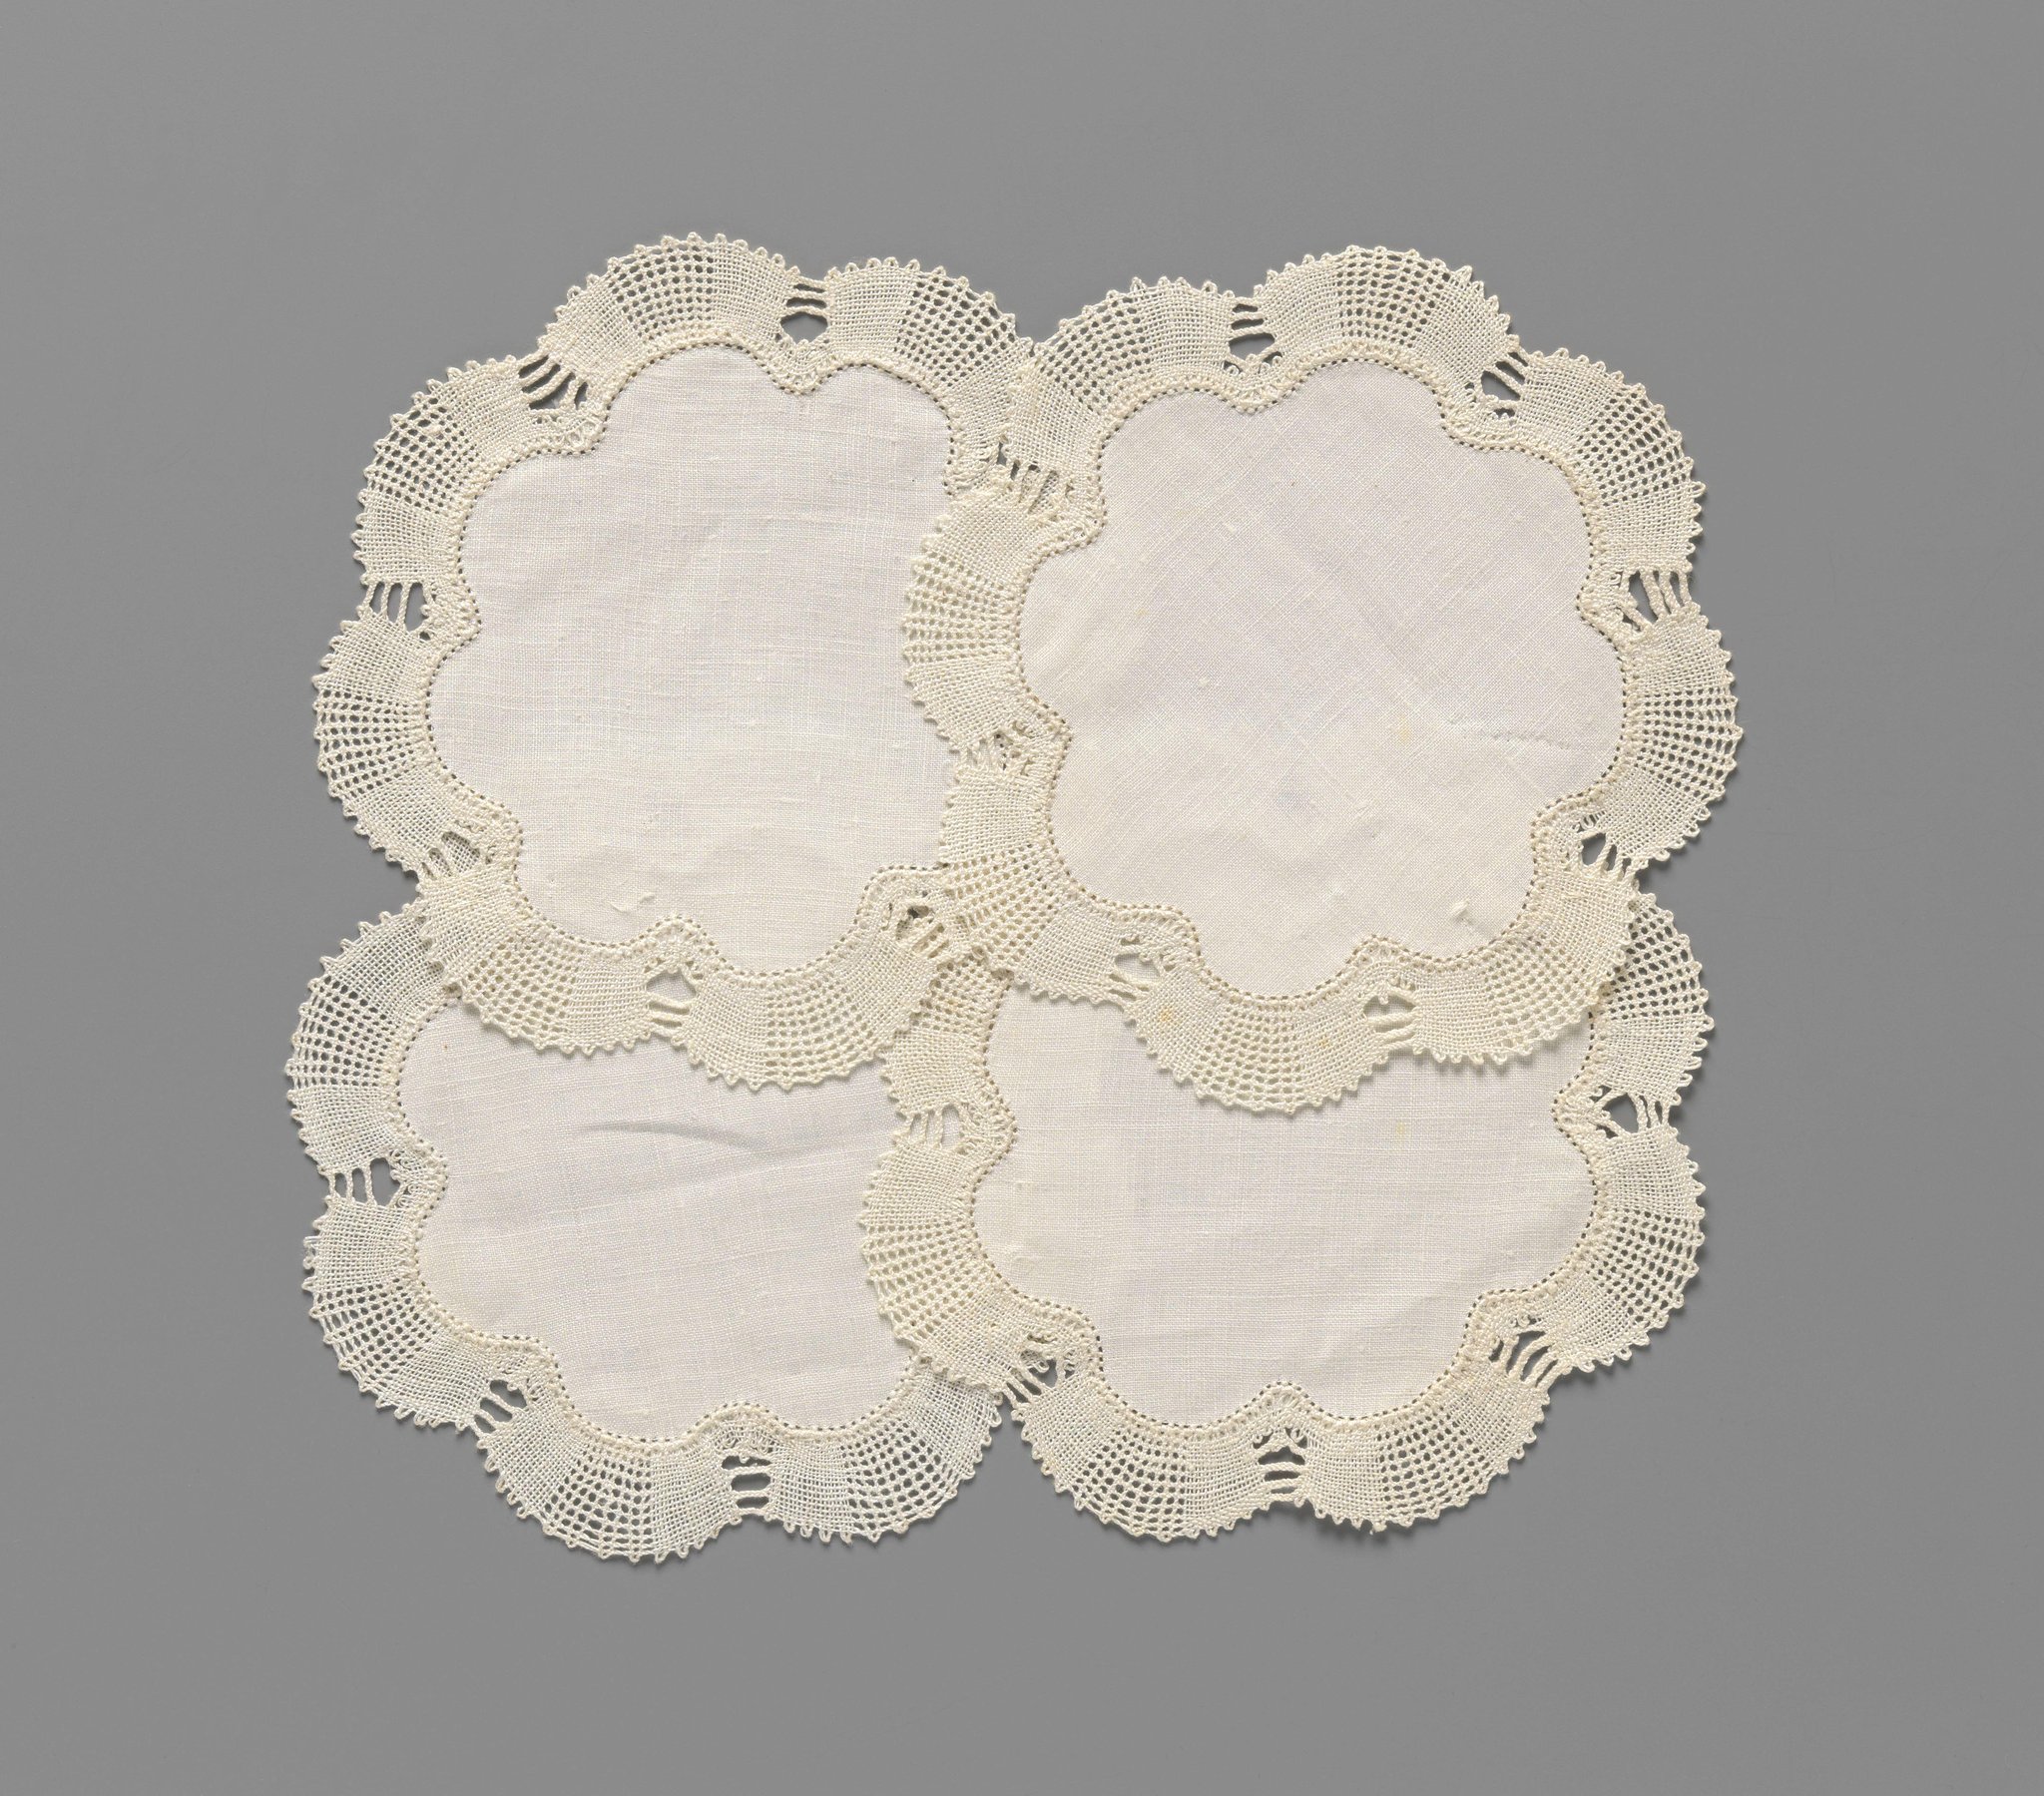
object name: doily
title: Doily van linnen rozetvormig met acht lobben en rondom een rand kloskant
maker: Anonymous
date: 1925-1949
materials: linen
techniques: lace, weave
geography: netherlands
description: Doily van naturelkleurig linnen met rondom een rand kloskant: Nederlandse kant. Rozetvormig model met acht halfcirkelvormige schulpen of lobben. De doily is met enkele steken vastgenaaid aan drie dezelfde kleedjes waardoor een groter kleedje wordt gevormd. Ze overlappen elkaar bijna voor de helft. Het gaat om een samenvoeging van de kleedjes met de volgende objectnummers: BK-1970-370-B, -C, -E en -F.